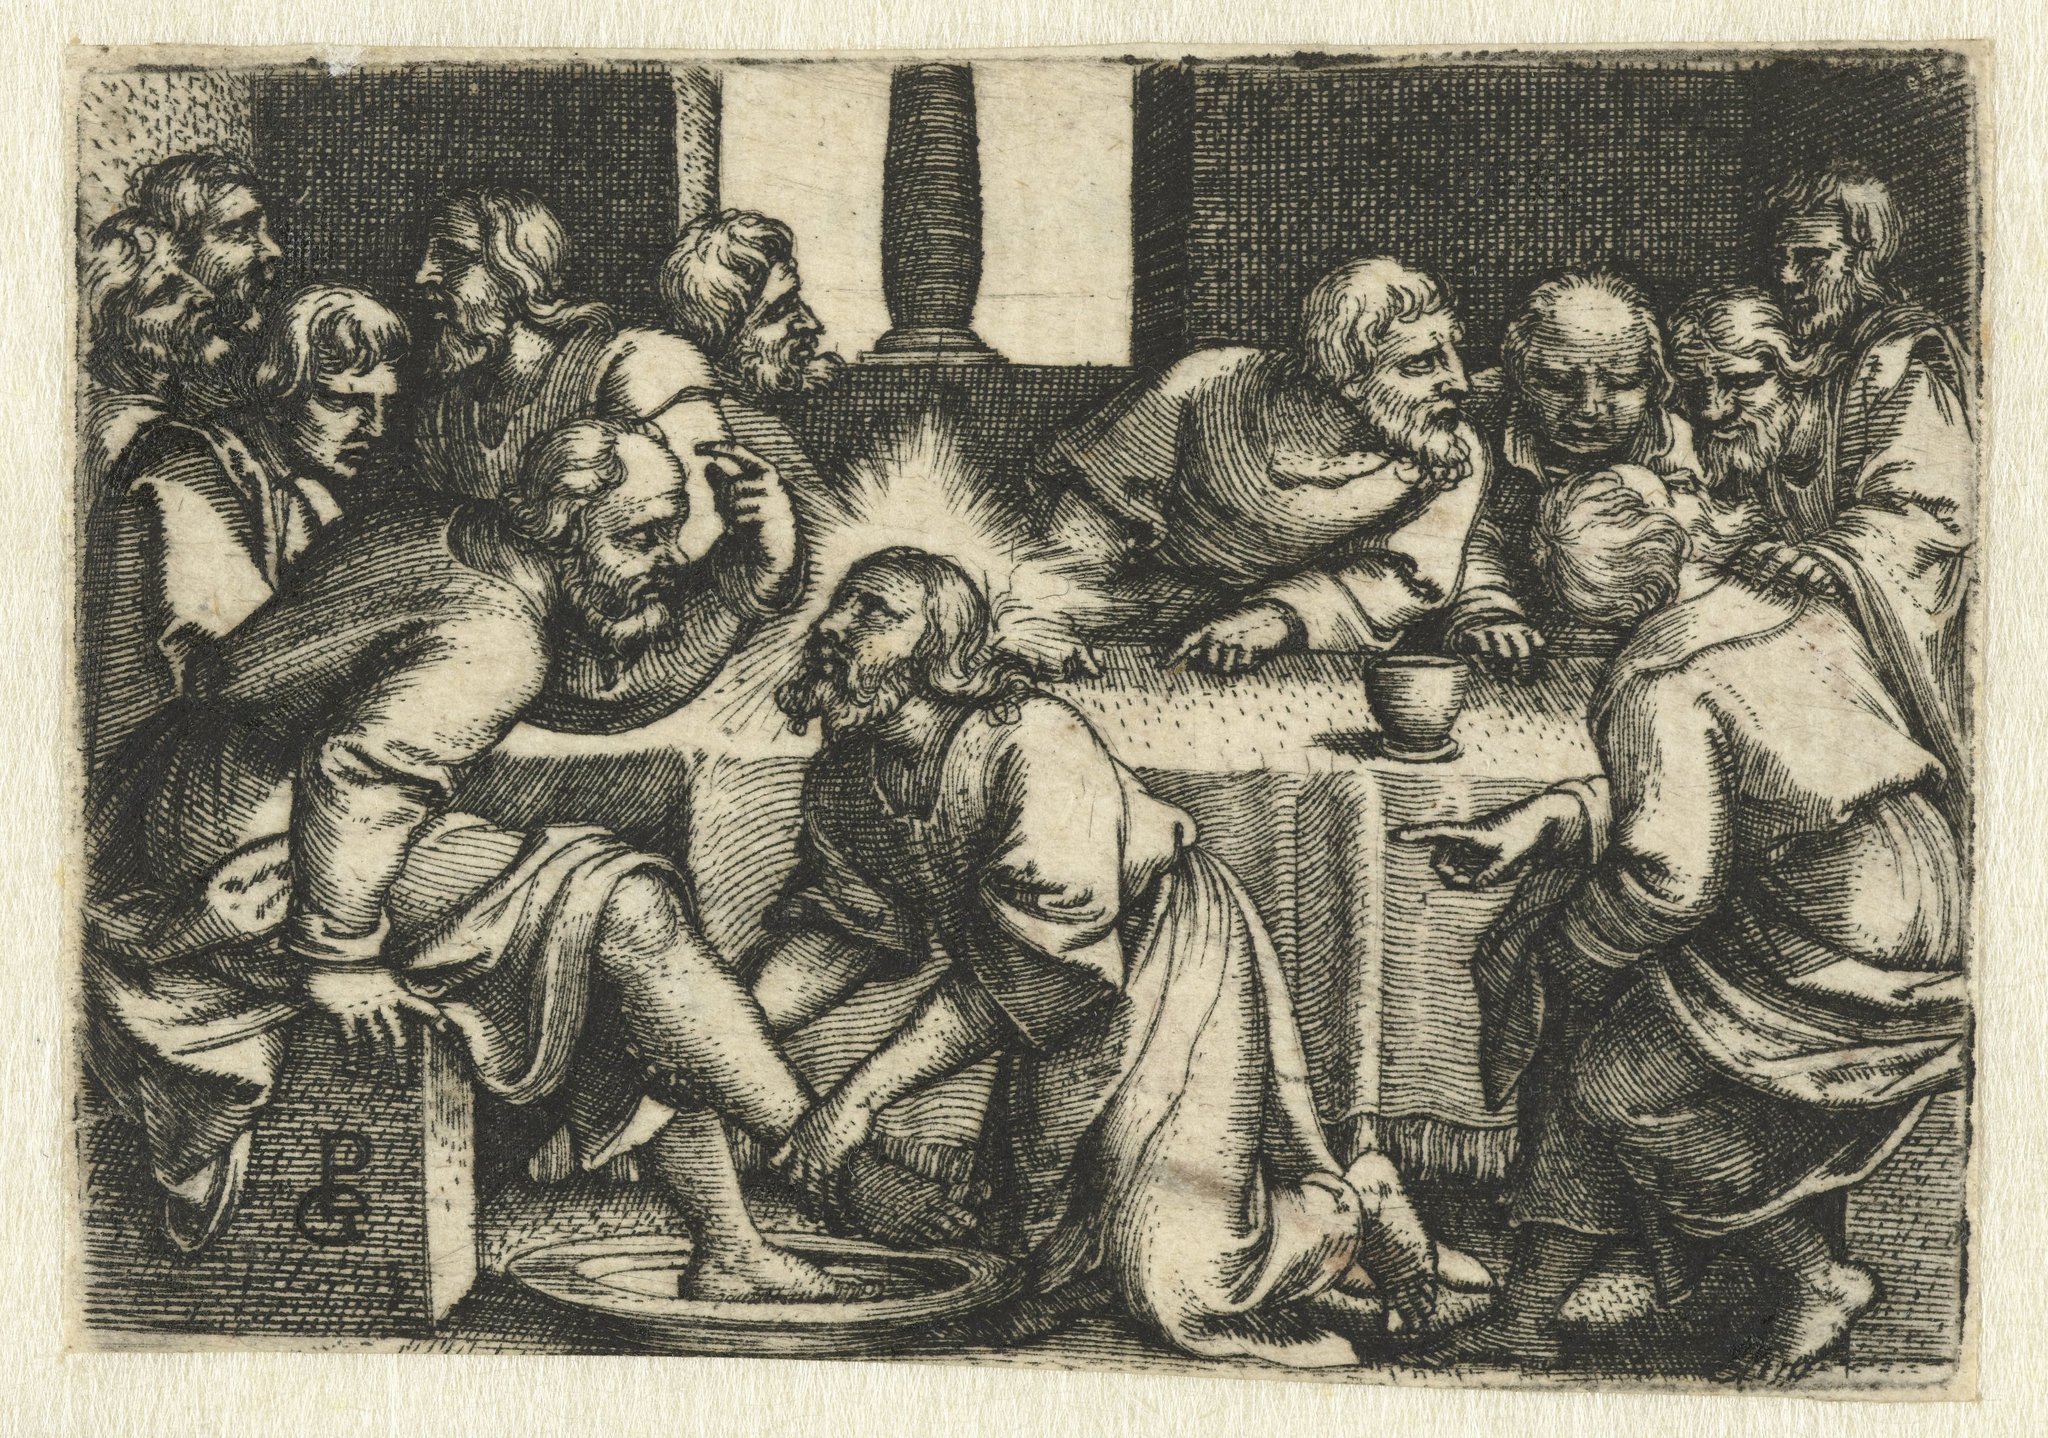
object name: print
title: Petrus protesteert als Christus zijn voeten wast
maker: georg pencz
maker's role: draughtsman, painter, print maker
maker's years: 1500-1550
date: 1535-1537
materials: paper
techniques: engraving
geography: germany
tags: christ washes peter's feet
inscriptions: collector's mark: Lugt 240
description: Volgens David Landau werd deze prent iets later (ca. 1535) aan de serie Leven van Christus toegevoegd. De prent is niet genummerd en is iets groter van formaat.